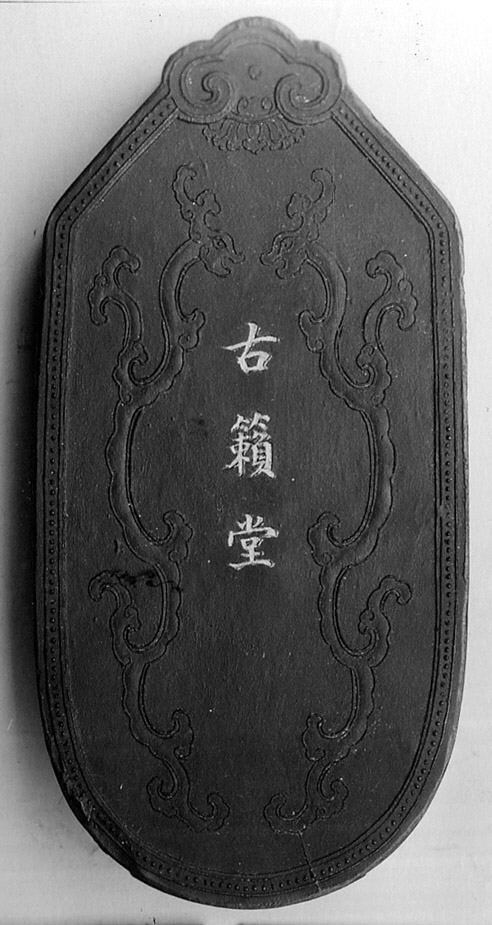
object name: ink tablet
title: Hall of Ancient Echoes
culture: chinese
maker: jian guzhai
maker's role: artist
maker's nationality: chinese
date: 1867-1933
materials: gilt, wood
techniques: bookbinding